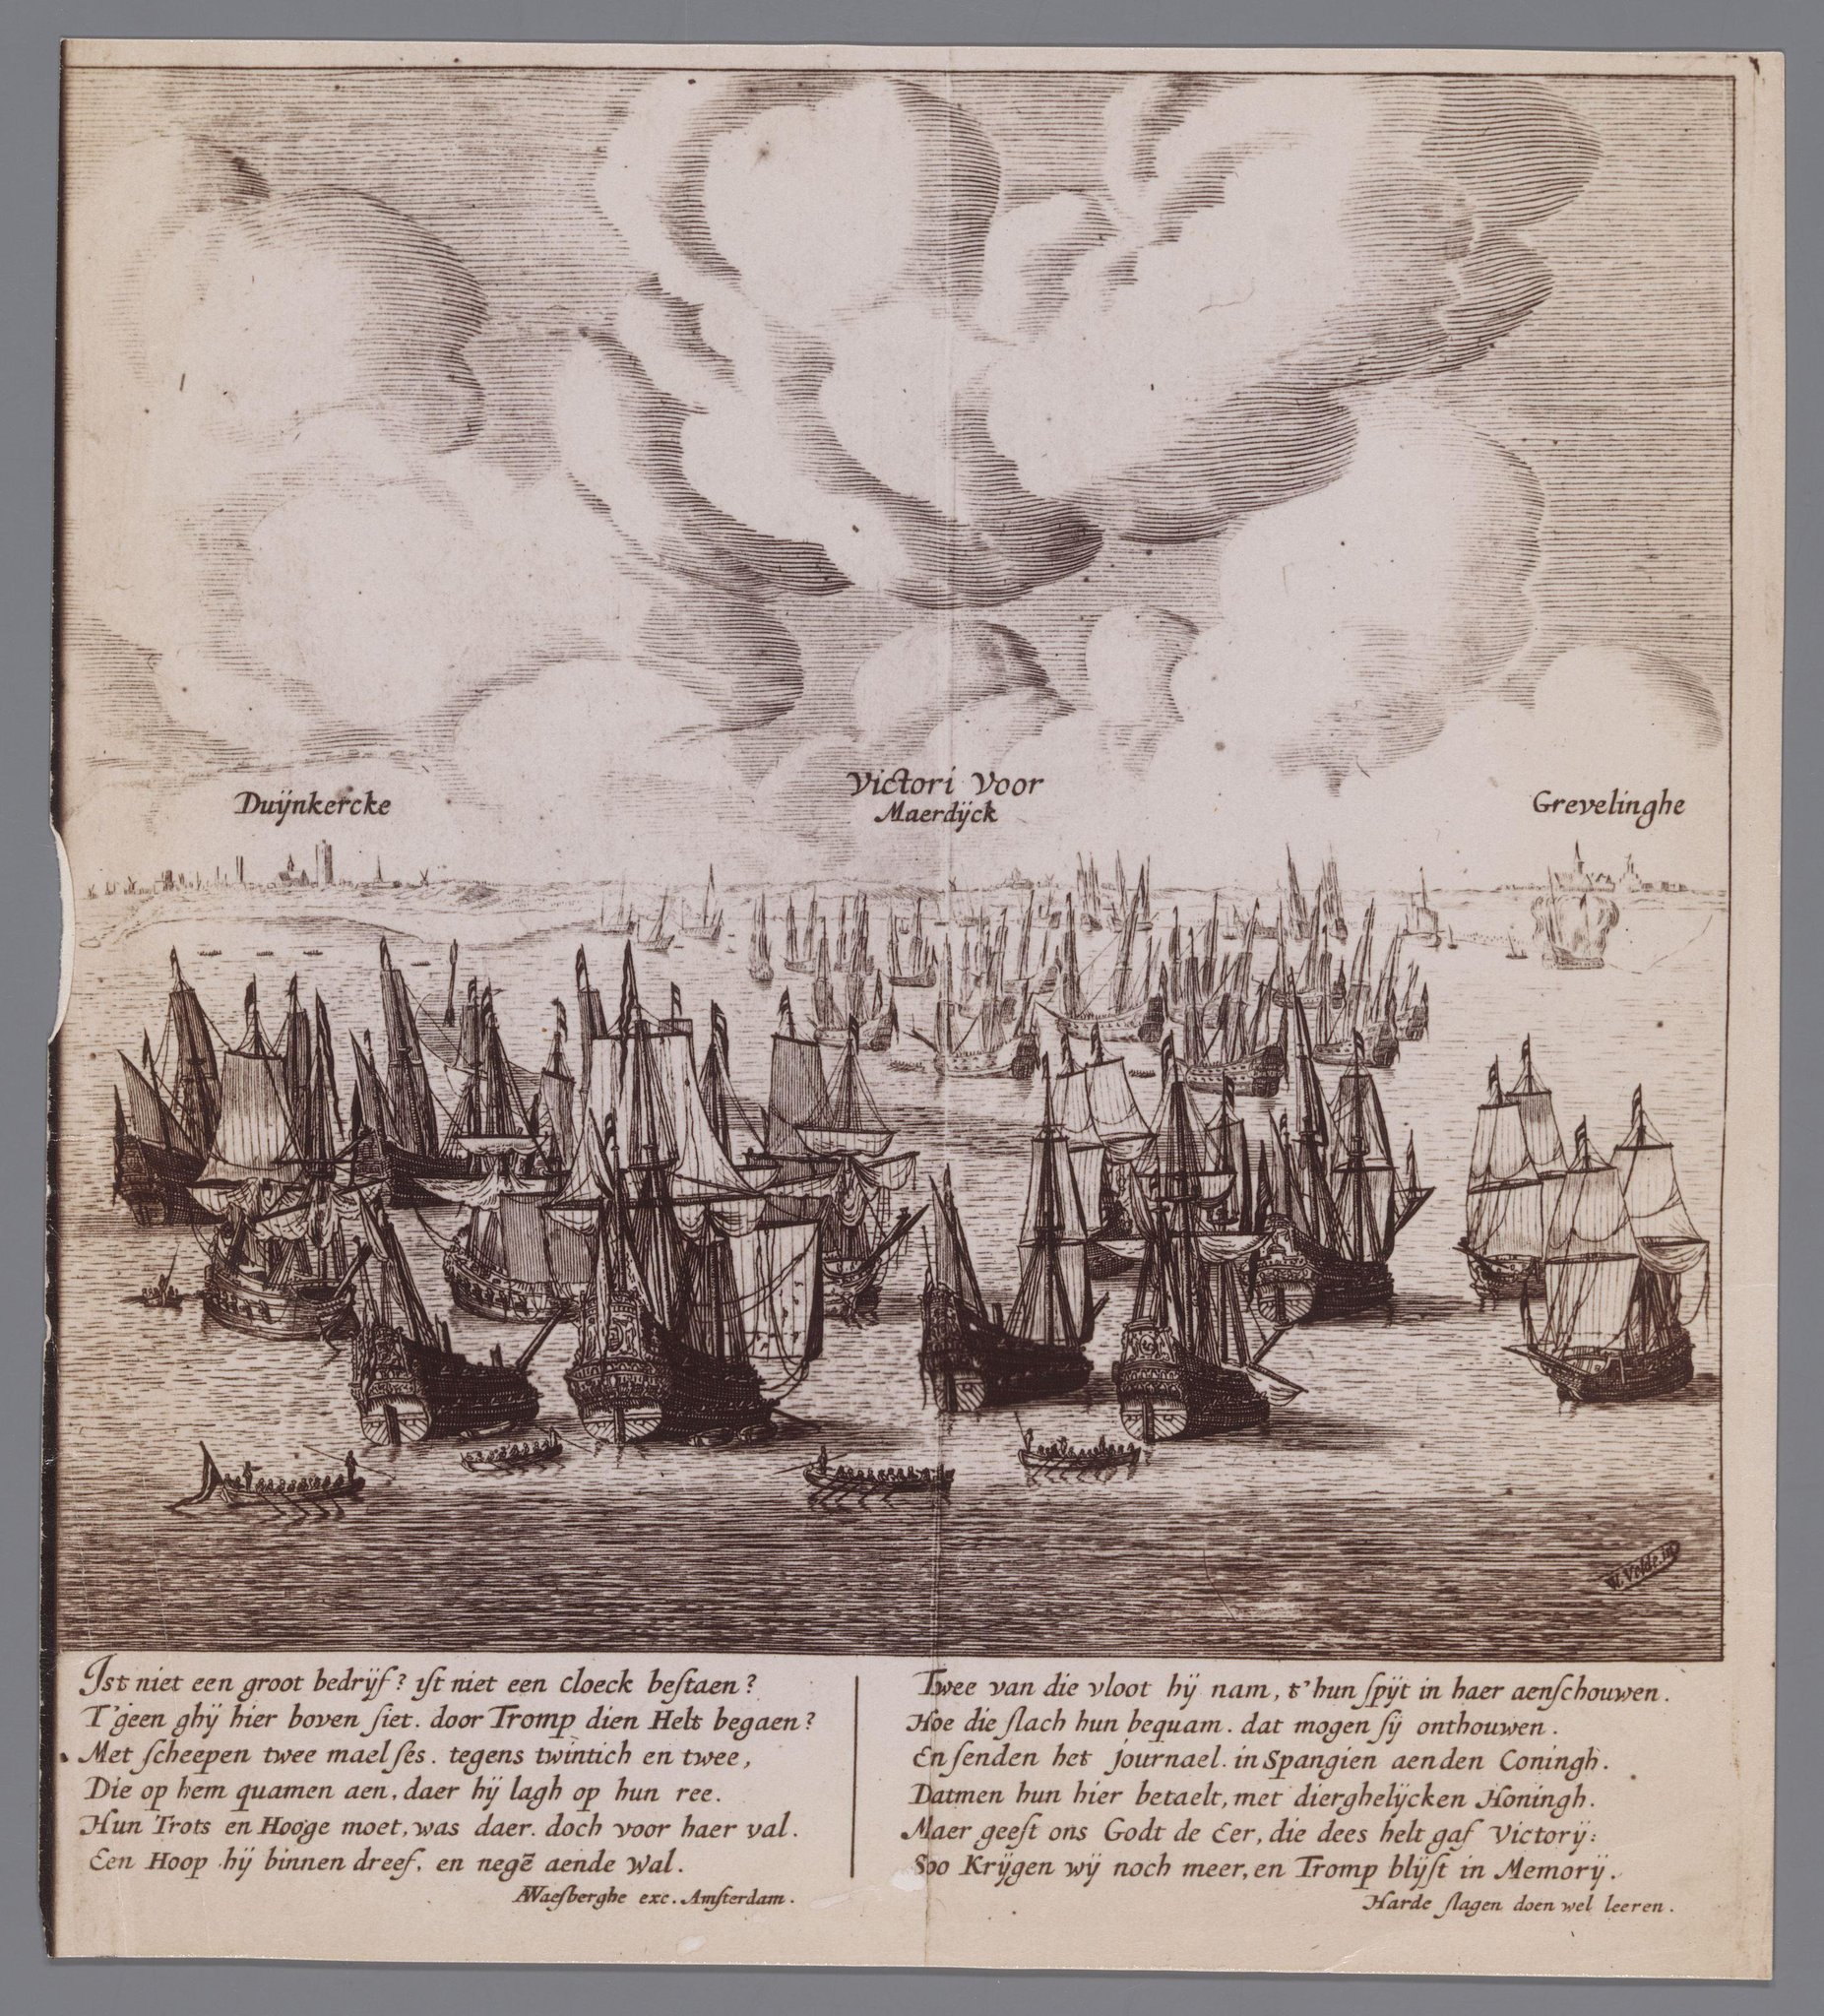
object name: photograph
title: Fotoreproductie van de prent Zeeslag voor Duinkerken onder Tromp naar Willem van de Velde (II)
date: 1870-1890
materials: paper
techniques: albumen print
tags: print, e.g.: engraving, etching, lithograph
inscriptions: inscription: ‘AA 372./ FM 1797A.’, collector's mark: Lugt 2228